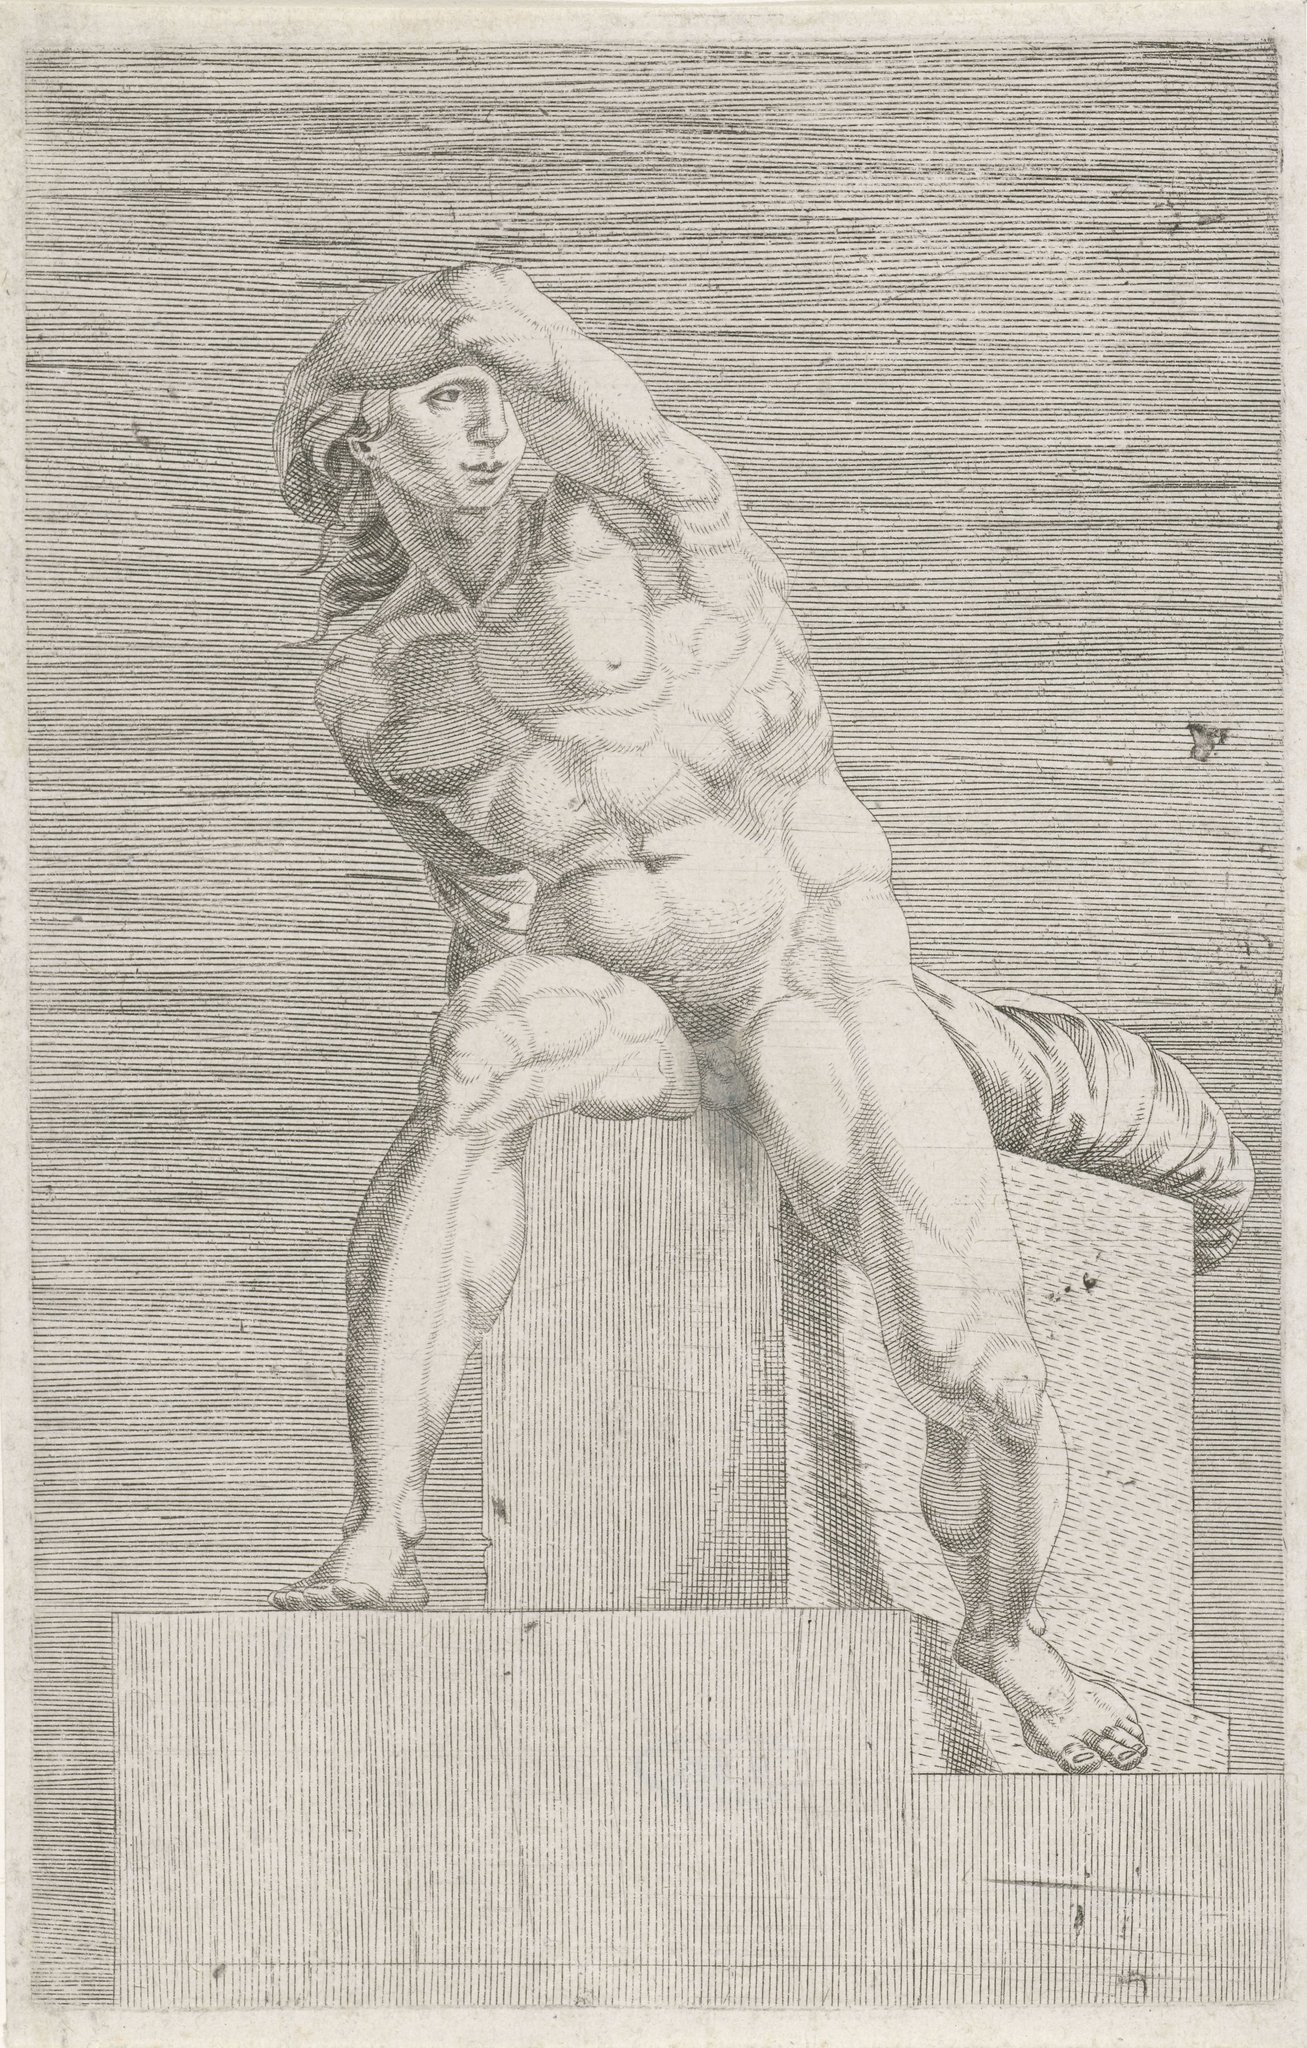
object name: print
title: Michelangelo's ignudi uit de Sixtijnse kapel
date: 1551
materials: paper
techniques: engraving, etching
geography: haarlem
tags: the (nude) human figure; 'corpo humano' (ripa)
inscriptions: collector's mark: Lugt 2228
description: Zittende naakte jongeman,van voren gezien. Uit serie van 20 prenten met Michelangelo's naakten in de Sixtijnse kapel.